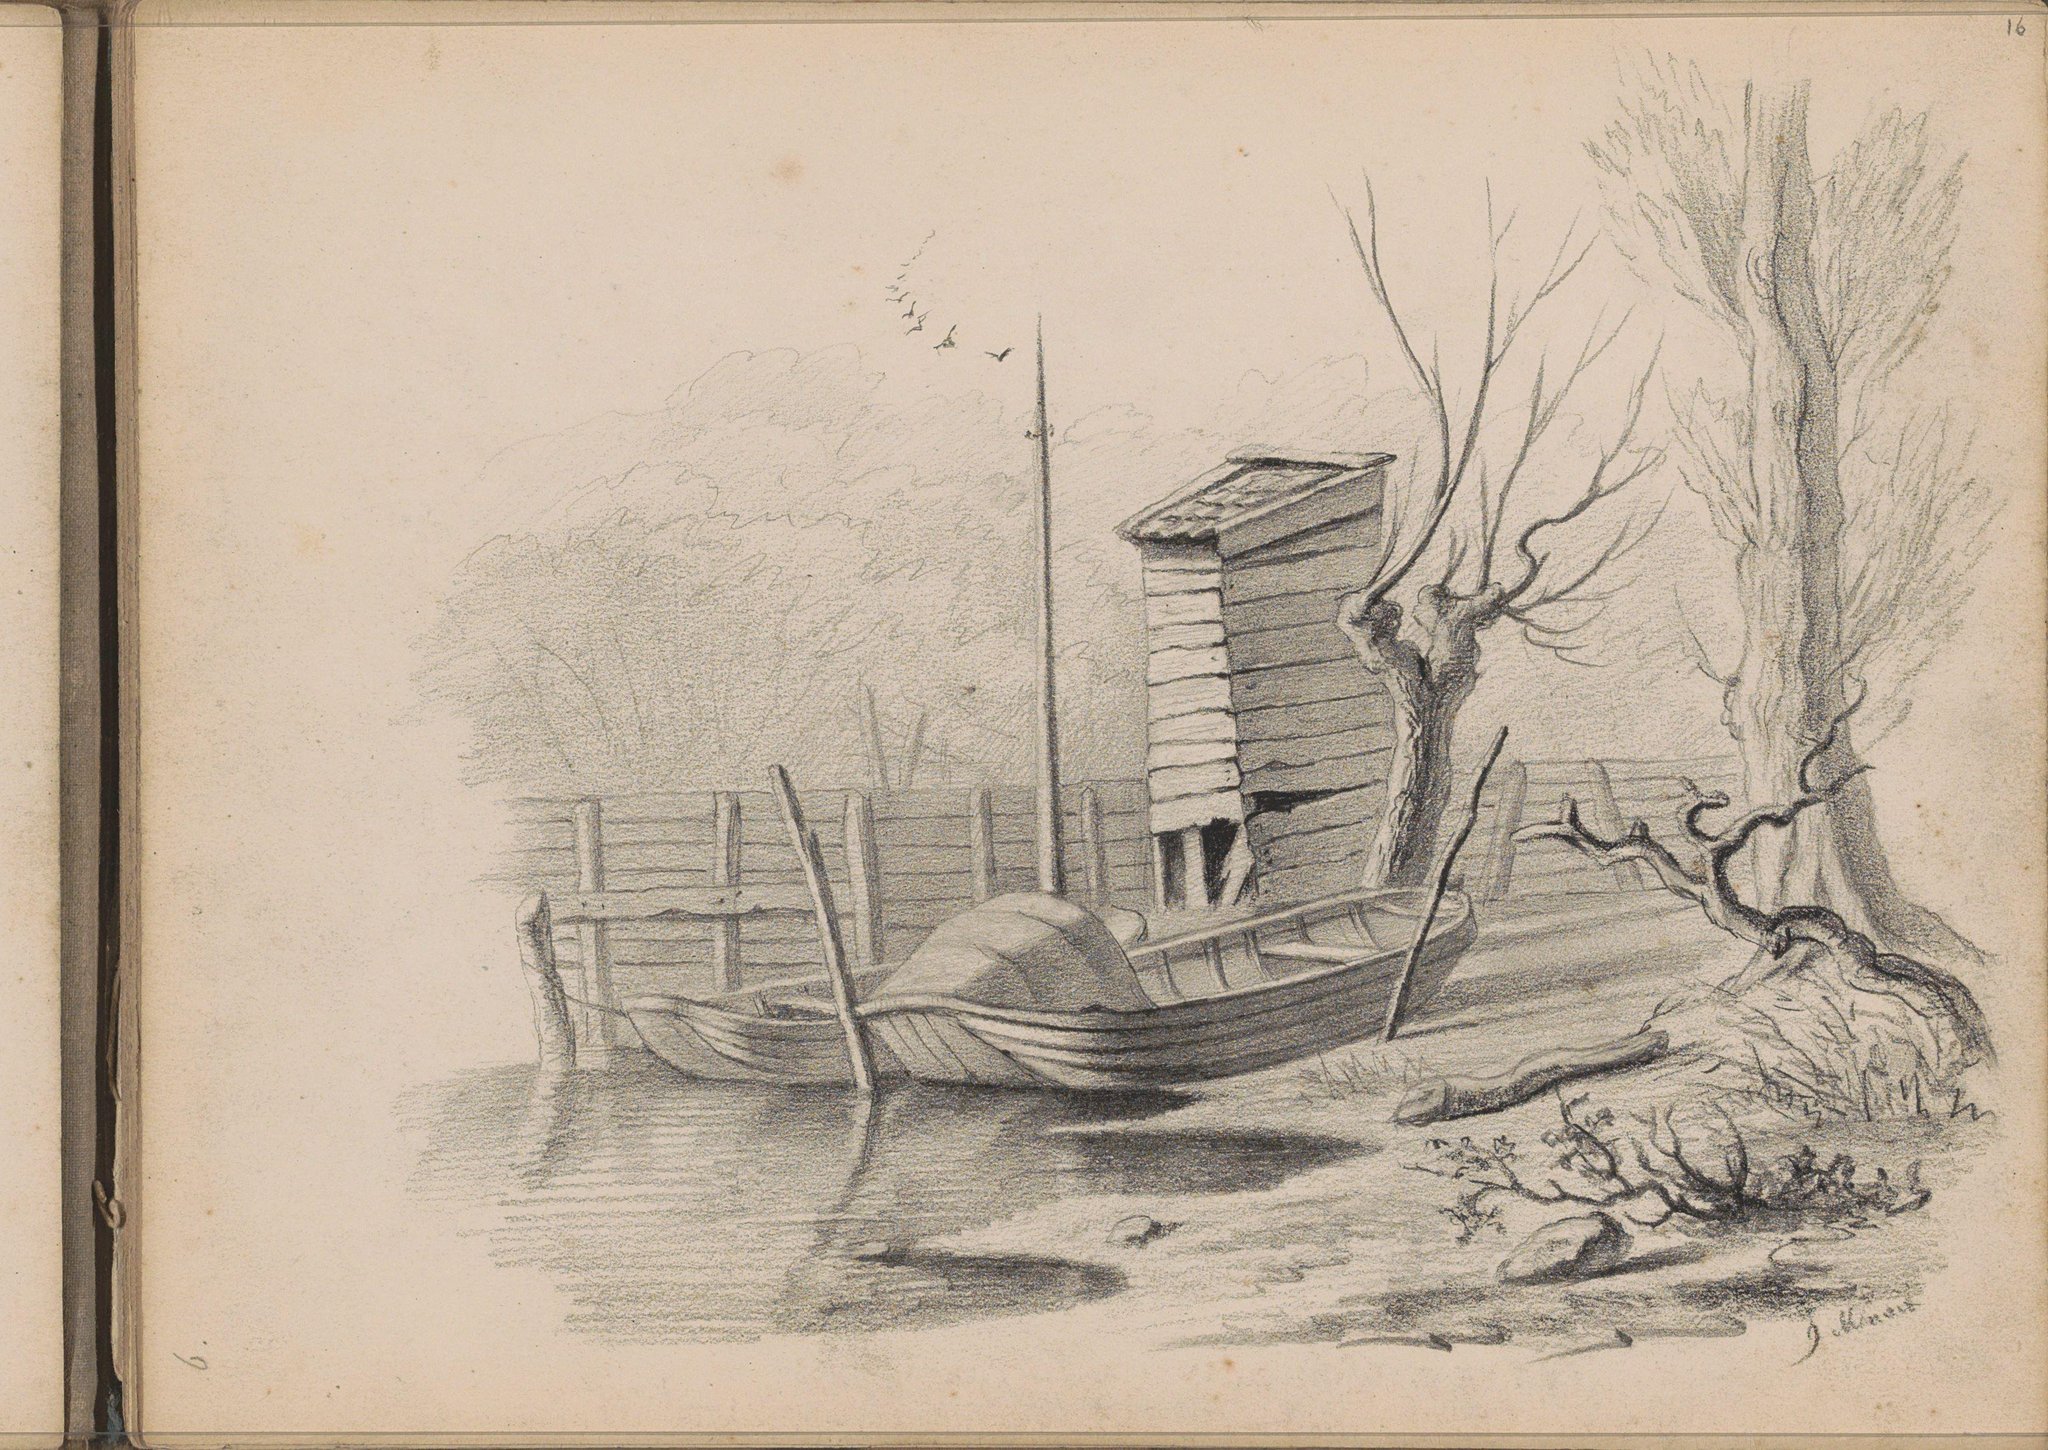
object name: sketchbook leaf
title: Roeiboten aan een waterkant met bomen en een hek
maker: willem cornelis rip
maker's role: draughtsman, painter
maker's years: 1856-1922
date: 1803-1874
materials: paper, pencil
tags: trees, fence, wall, paling, landscapes with waters, waterscapes, seascapes (in the temperate zone), rowing-boat, canoe, etc.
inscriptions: date: ‘9 Maart’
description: Blad 16 recto uit een schetsboek met 27 losse bladen.